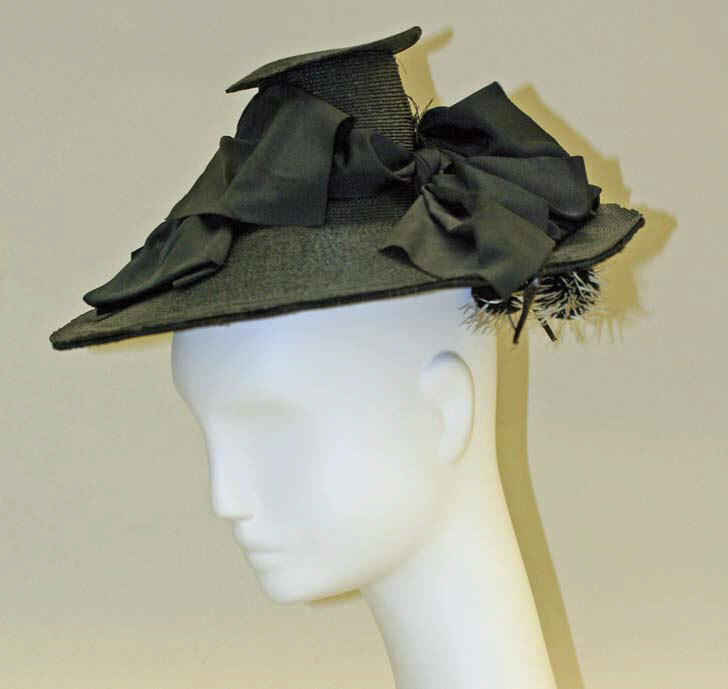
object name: hat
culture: american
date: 1890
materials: silk, fiber